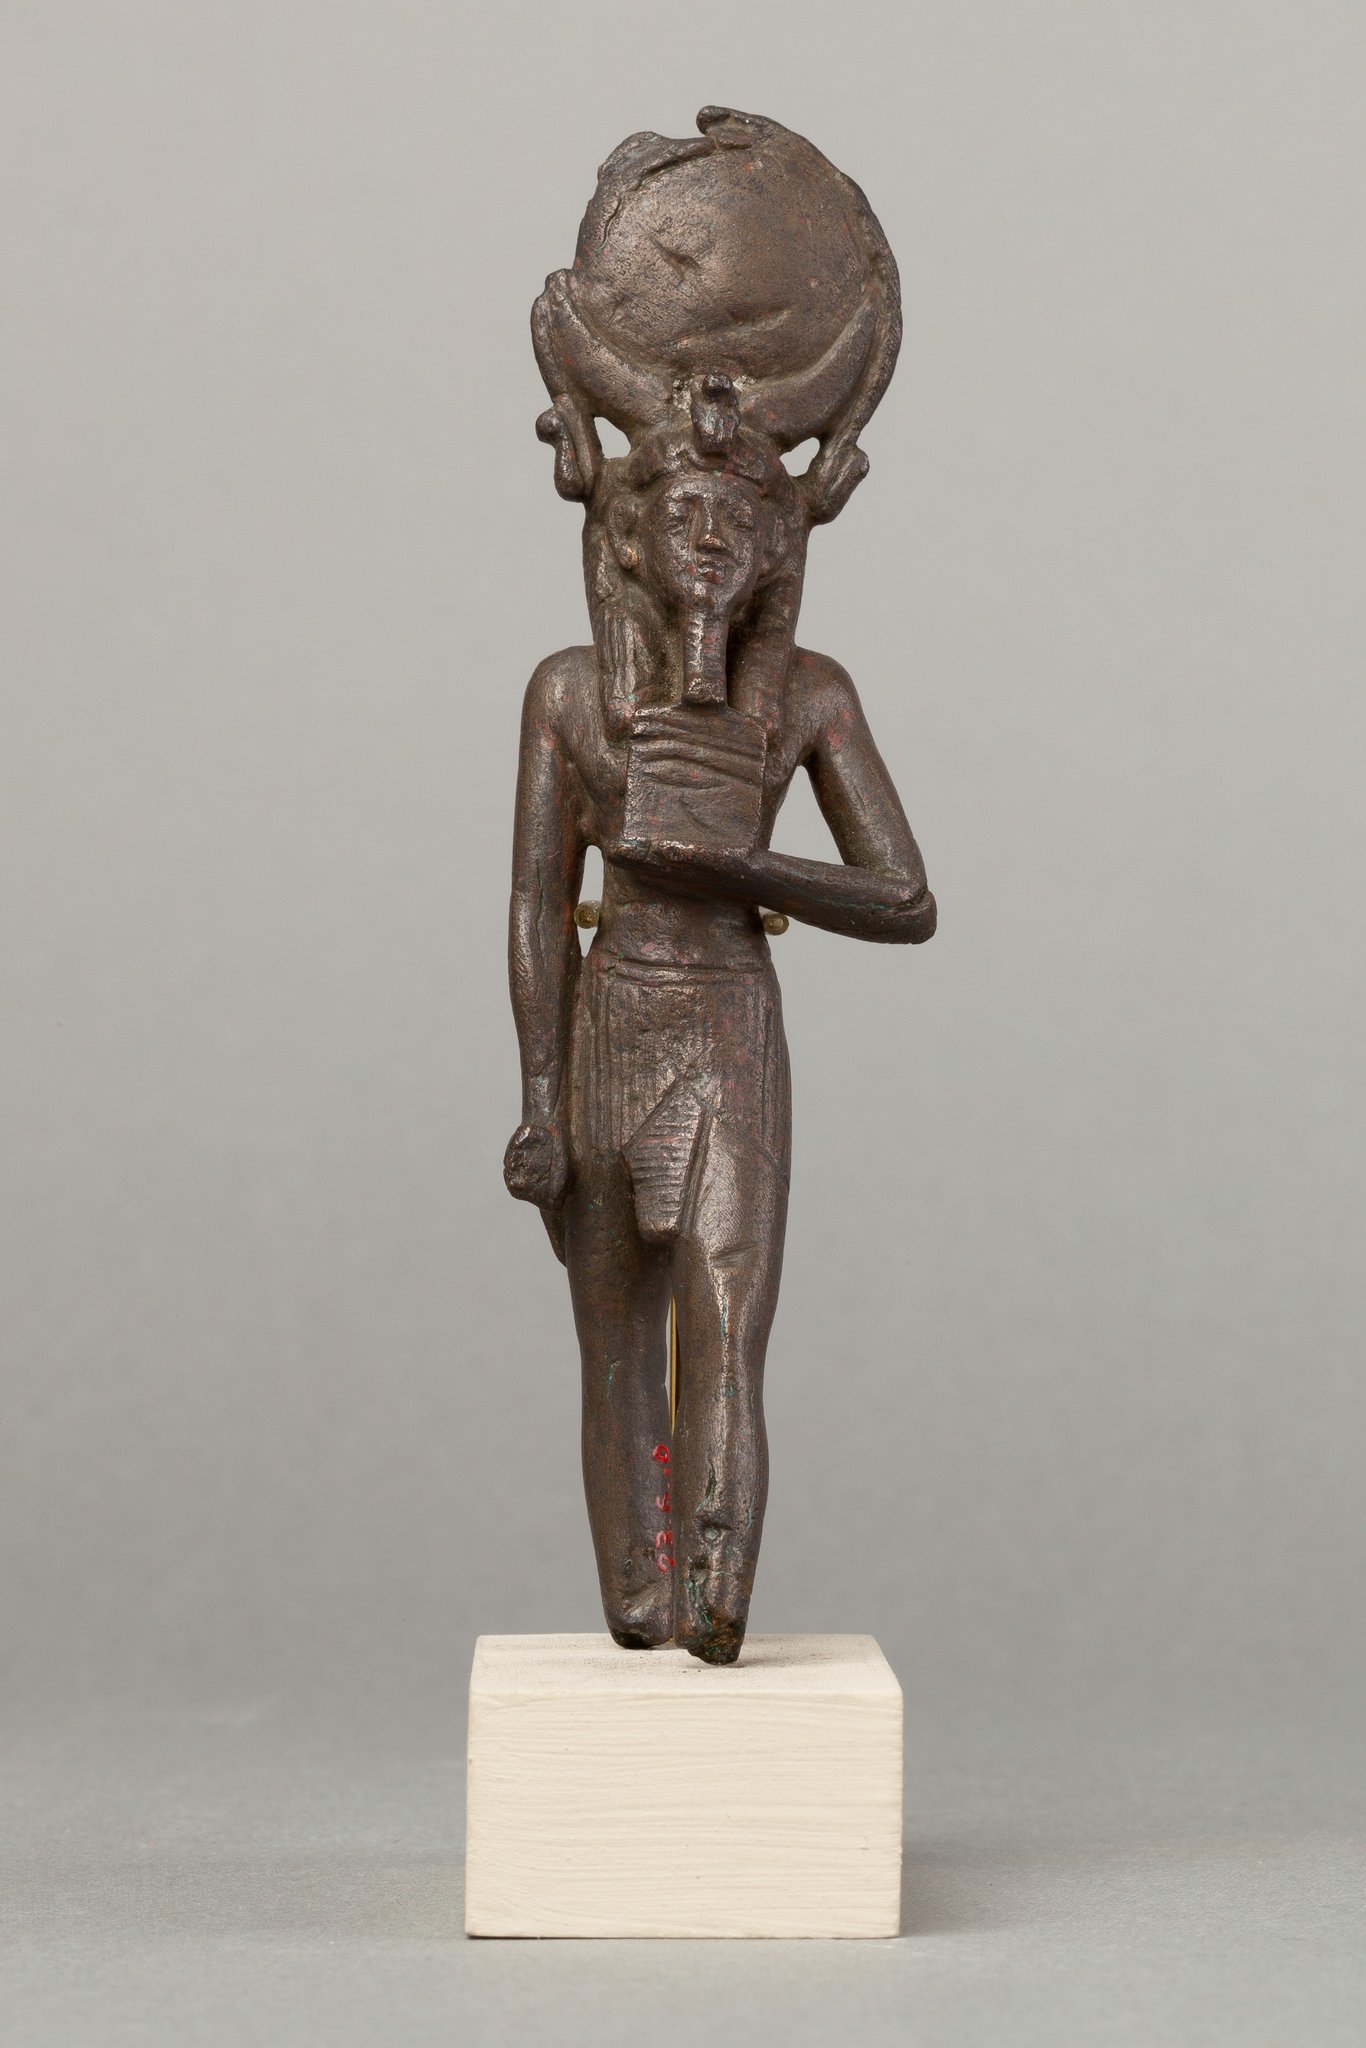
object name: statuette, osiris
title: Osiris-Iah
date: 664-630 BCE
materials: metal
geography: egypt